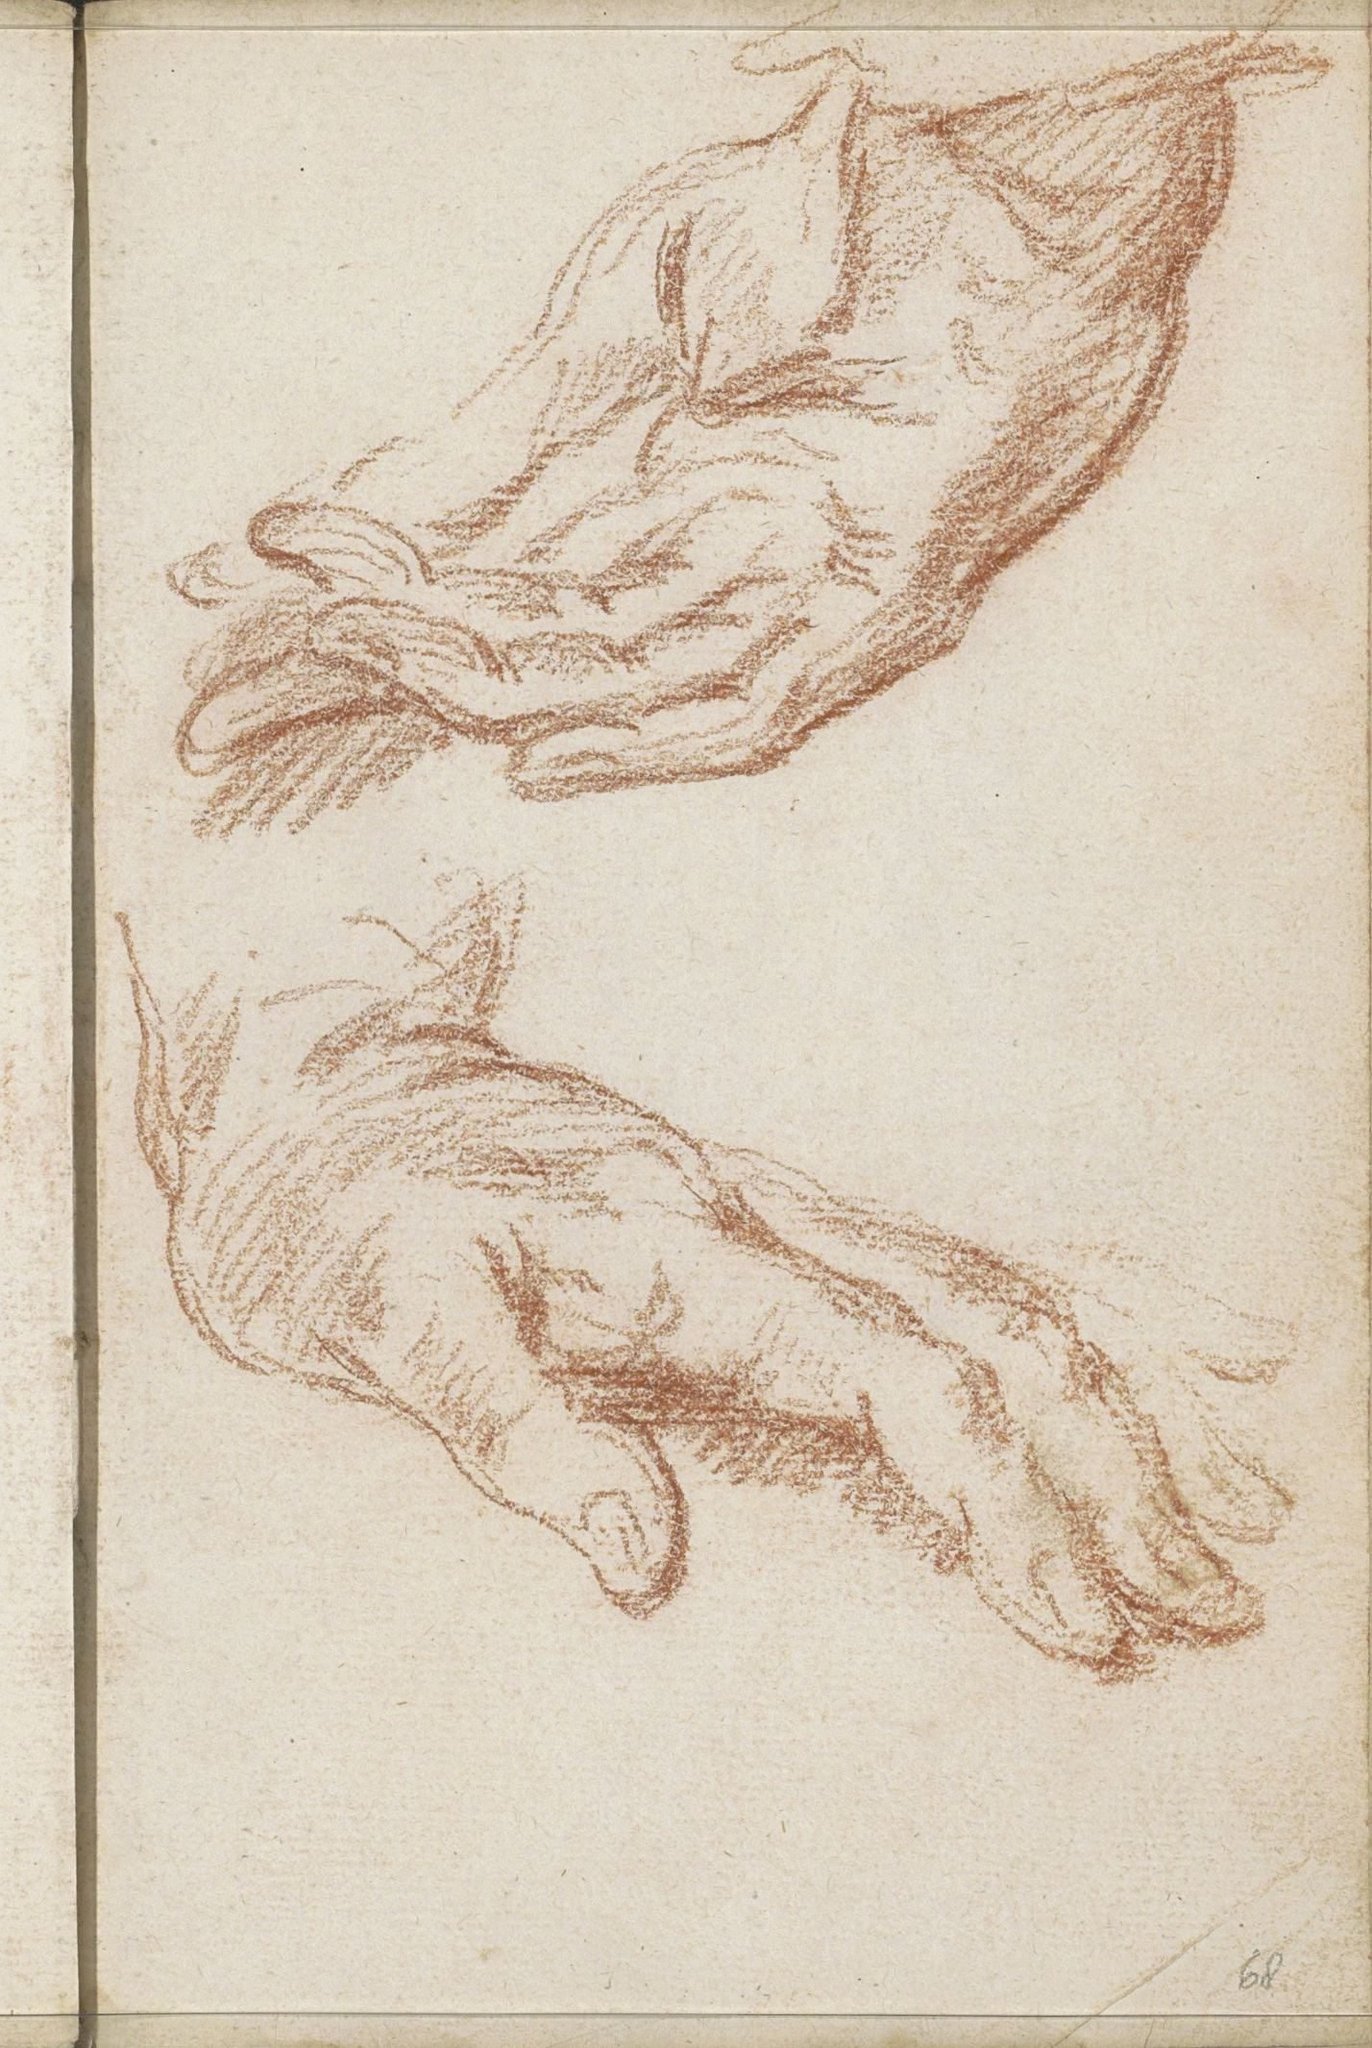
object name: sketchbook leaf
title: Twee handen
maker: petrus johannes van reysschoot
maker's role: draughtsman, print maker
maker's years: 1702-1772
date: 1710-1772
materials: chalk, paper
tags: hand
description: Blad 68 recto uit een schetsboek met 105 bladen.